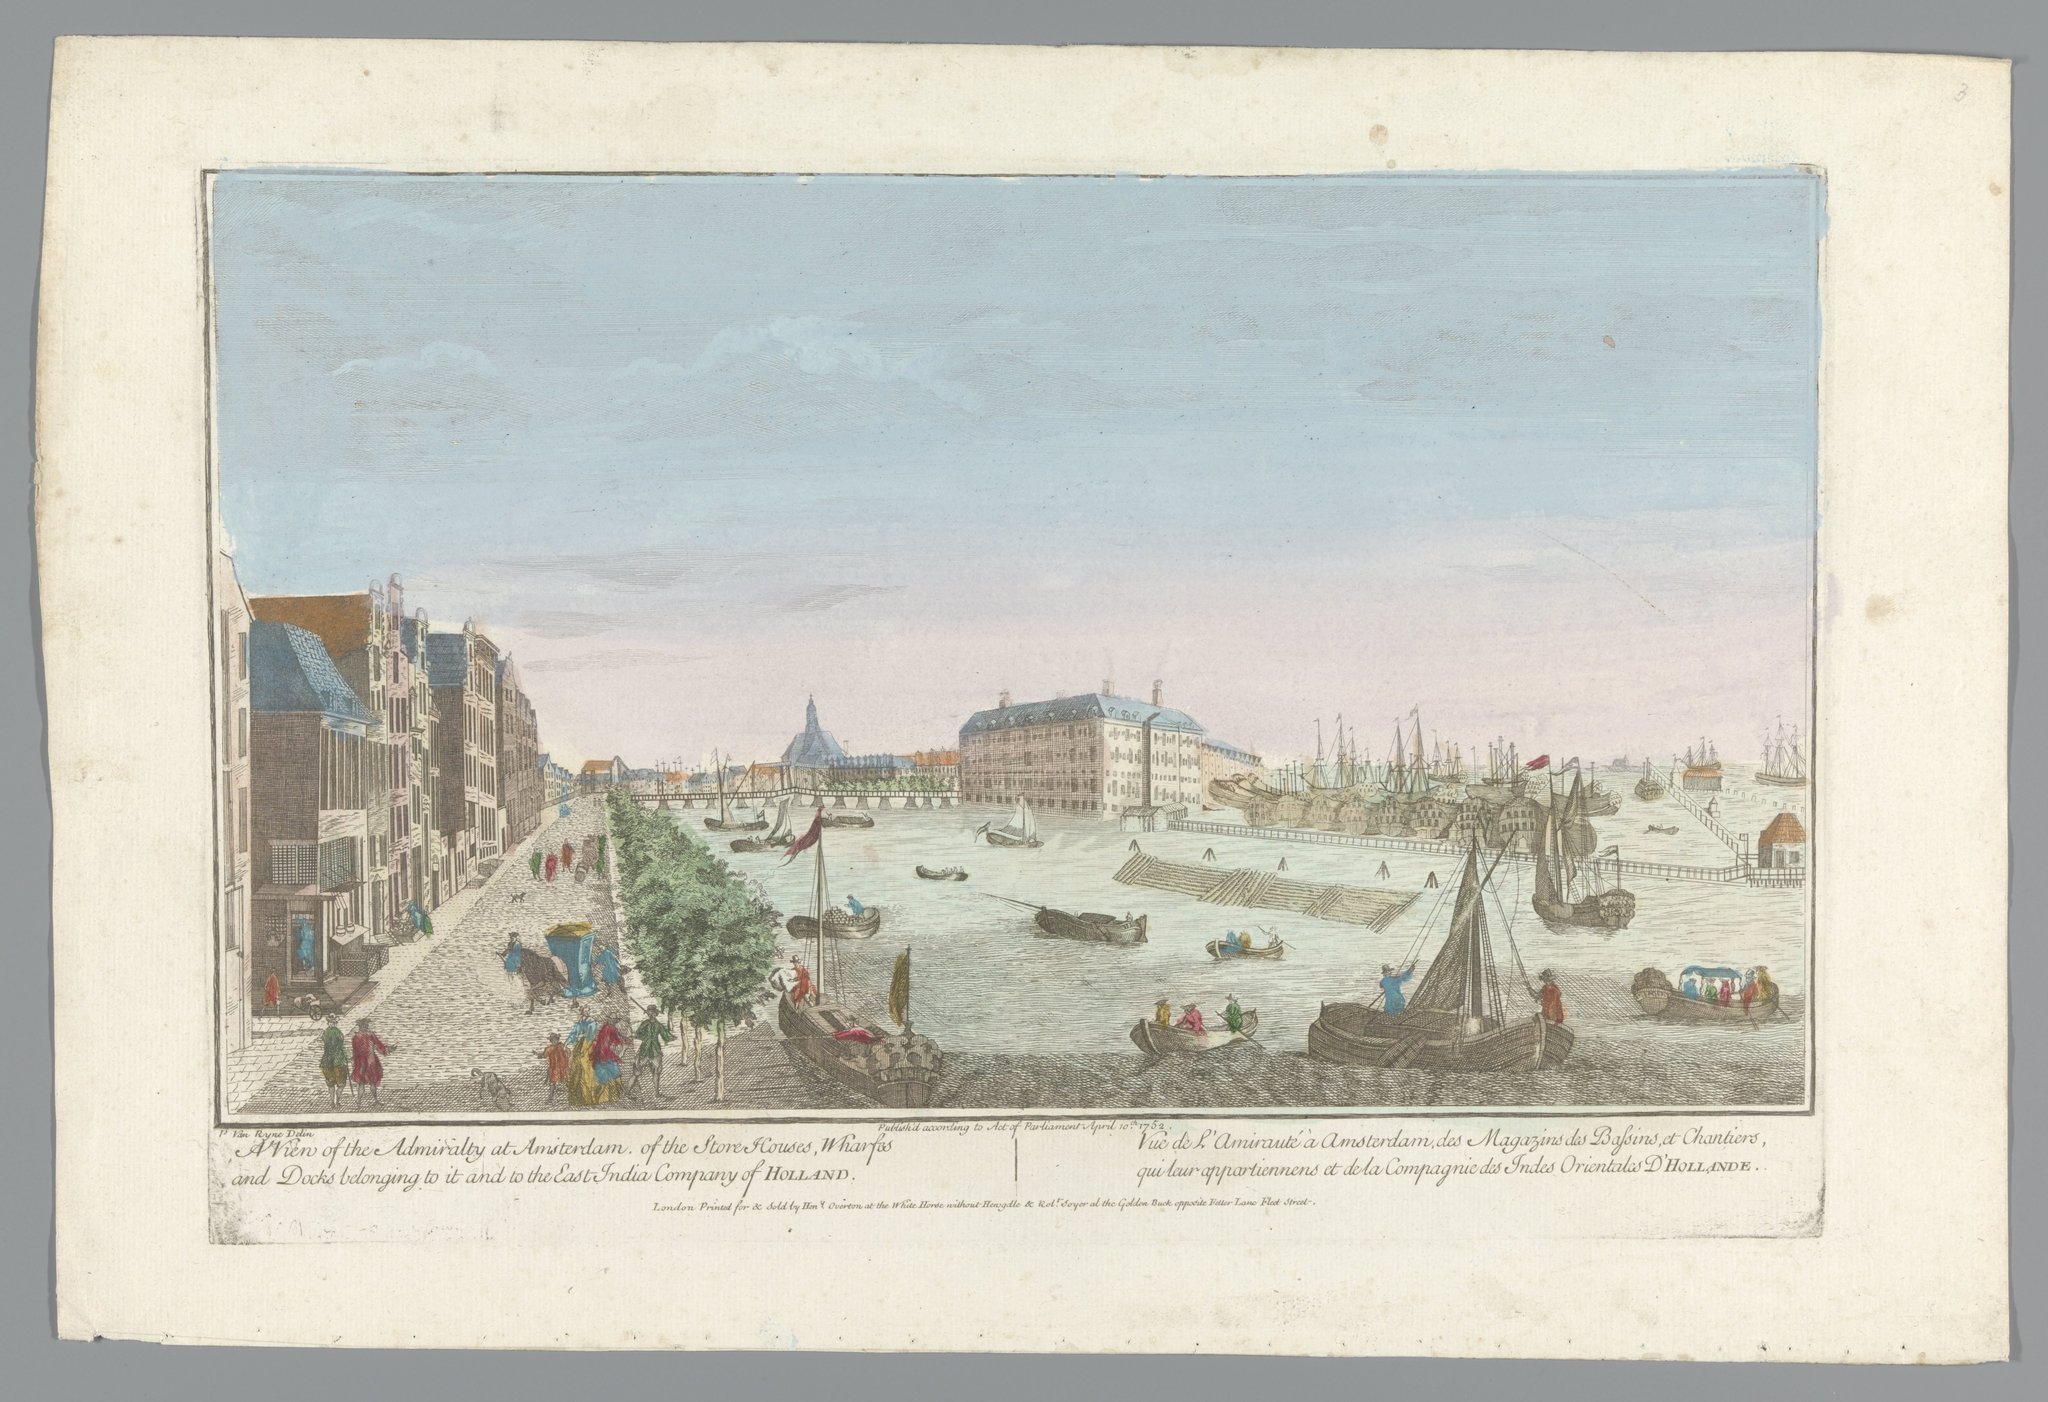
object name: print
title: A view of the Admiralty at Amsterdam, of the store houses, wharfes and docks, belonging to it and to the East India Company of Holland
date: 1752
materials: paper, watercolor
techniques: brush, etching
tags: large-scale structure for storage, e.g.: warehouse, depot, silo, bridge in city across river, canal, etc. (+ city(-scape) with figures, staffage), sailing-ship, sailing-boat, rowing-boat, canoe, etc., gate, entrance, canals, waters (in city) (+ city(-scape) with figures, staffage)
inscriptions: watermark, collector's mark: Lugt 2166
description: De signaturen van de uitgevers Robert Sayer en Henry (II) Overton en mogelijk ook de datering zijn mee gekopieerd.